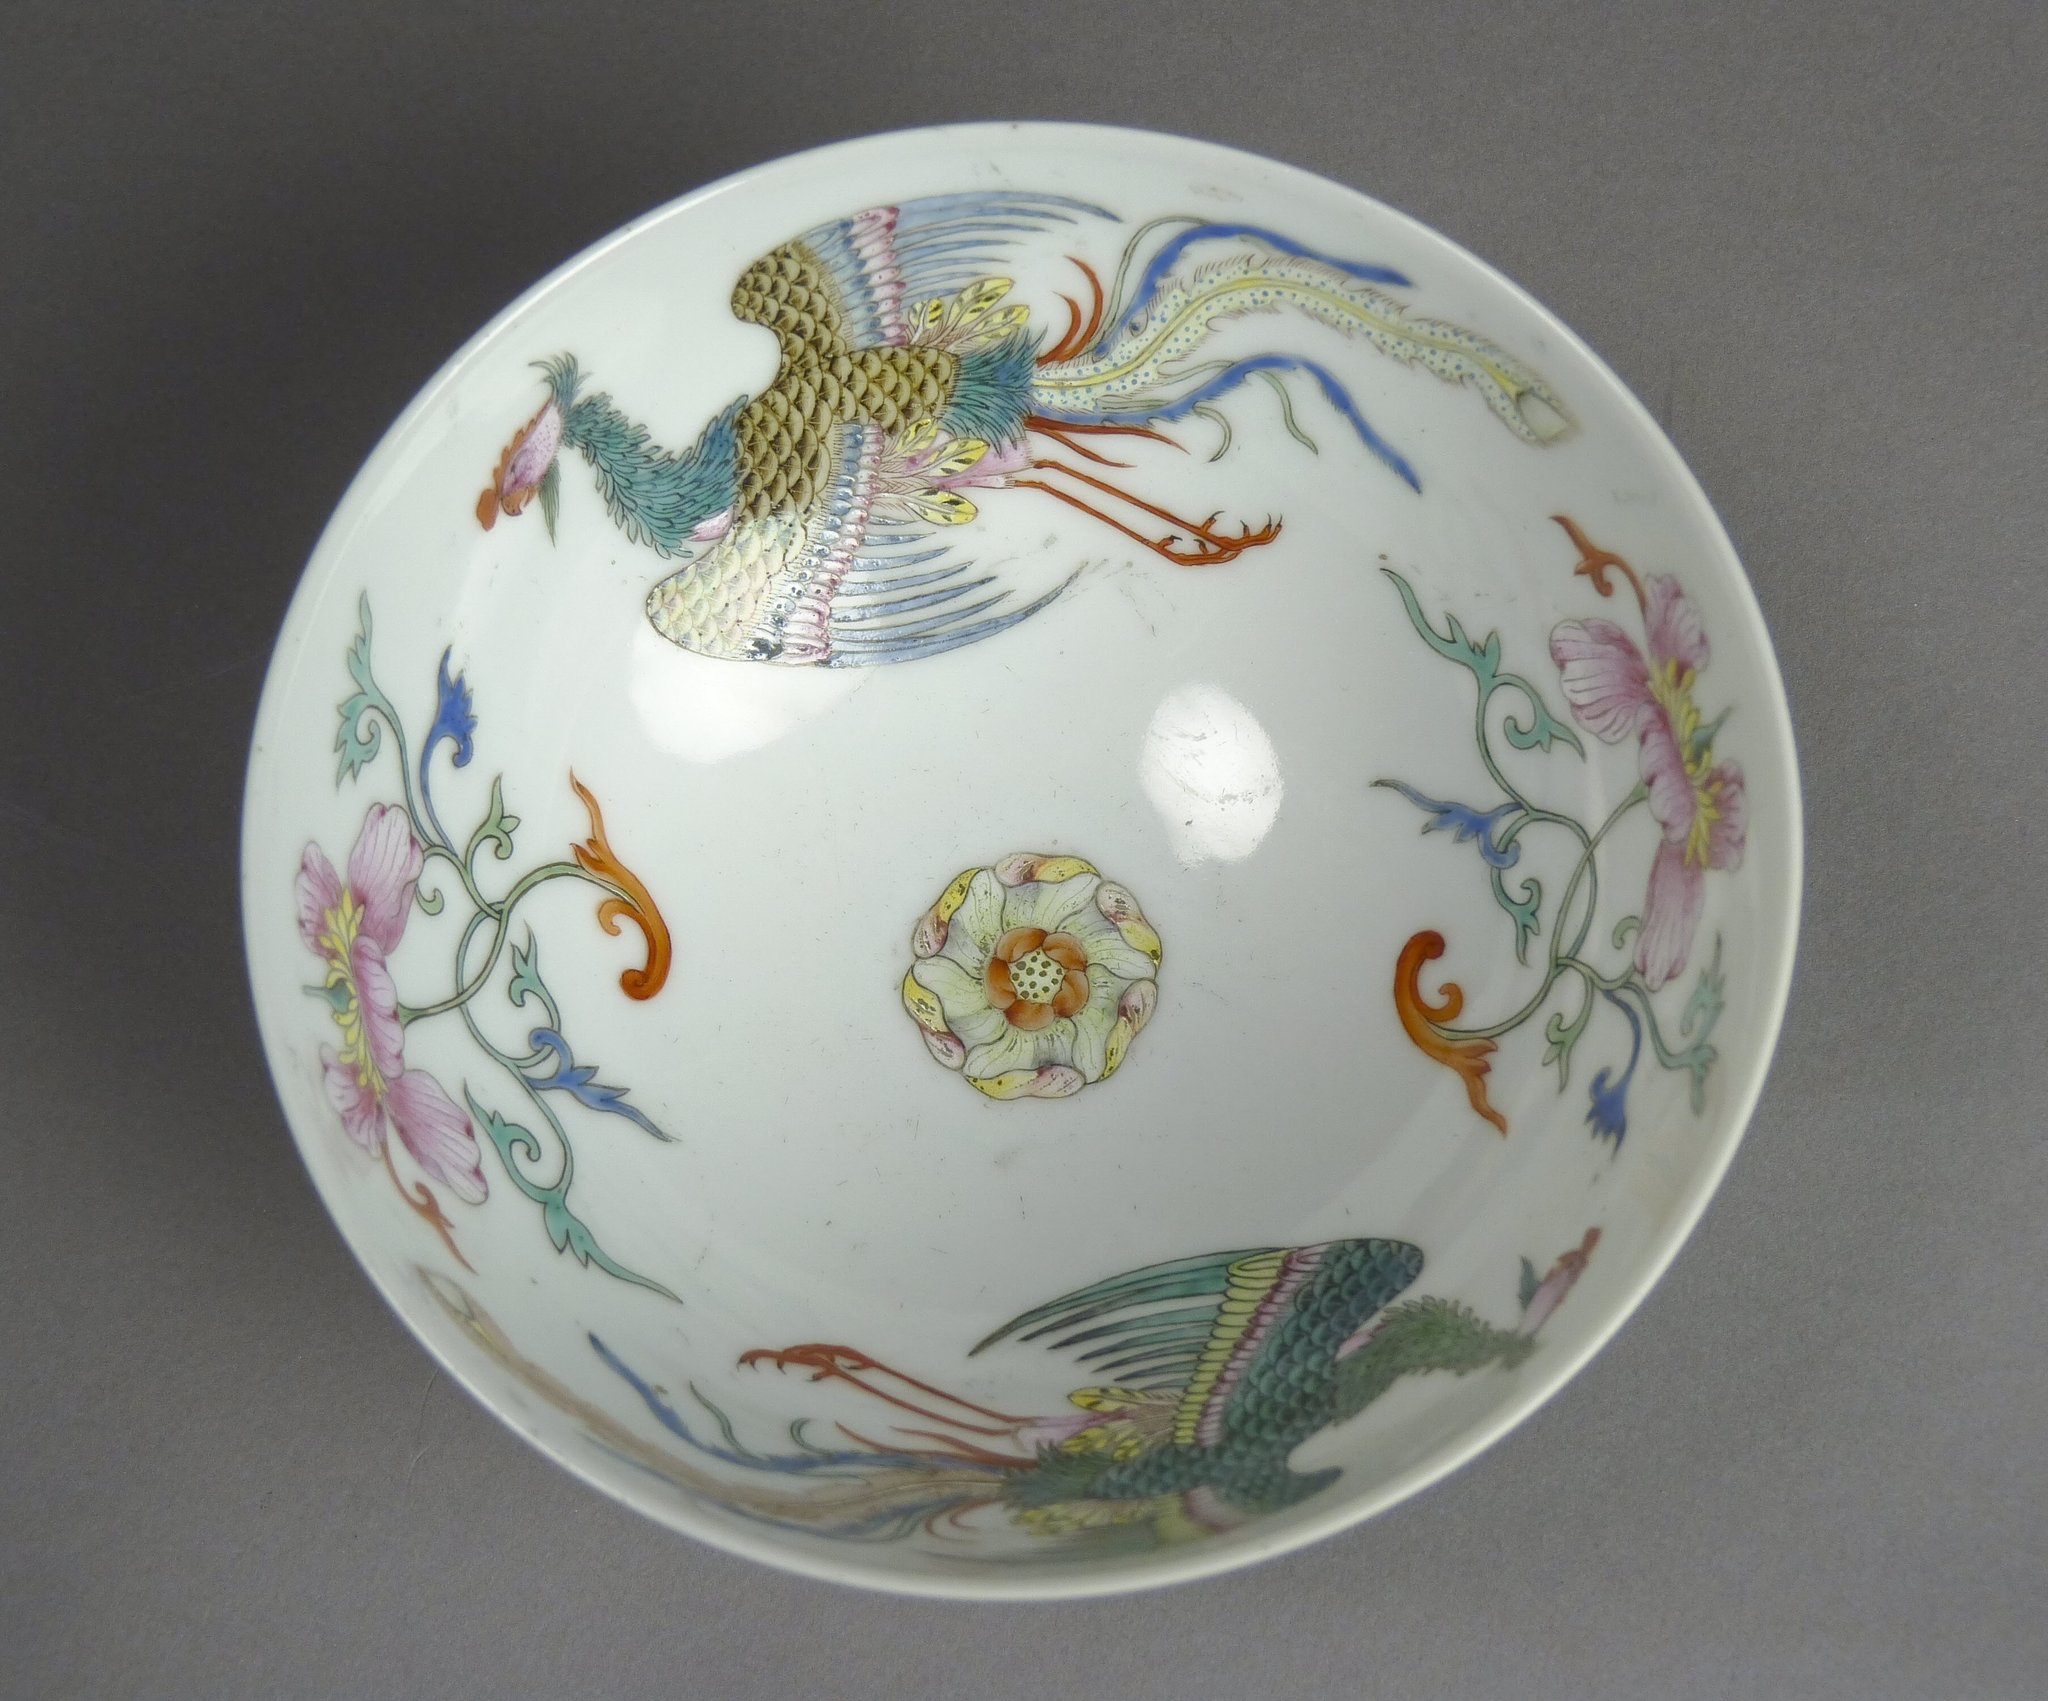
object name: bowl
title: Bowl with Phoenixes and Flowers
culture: chinese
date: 1736-1795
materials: enamel, porcelain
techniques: overglaze, painting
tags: phoenix